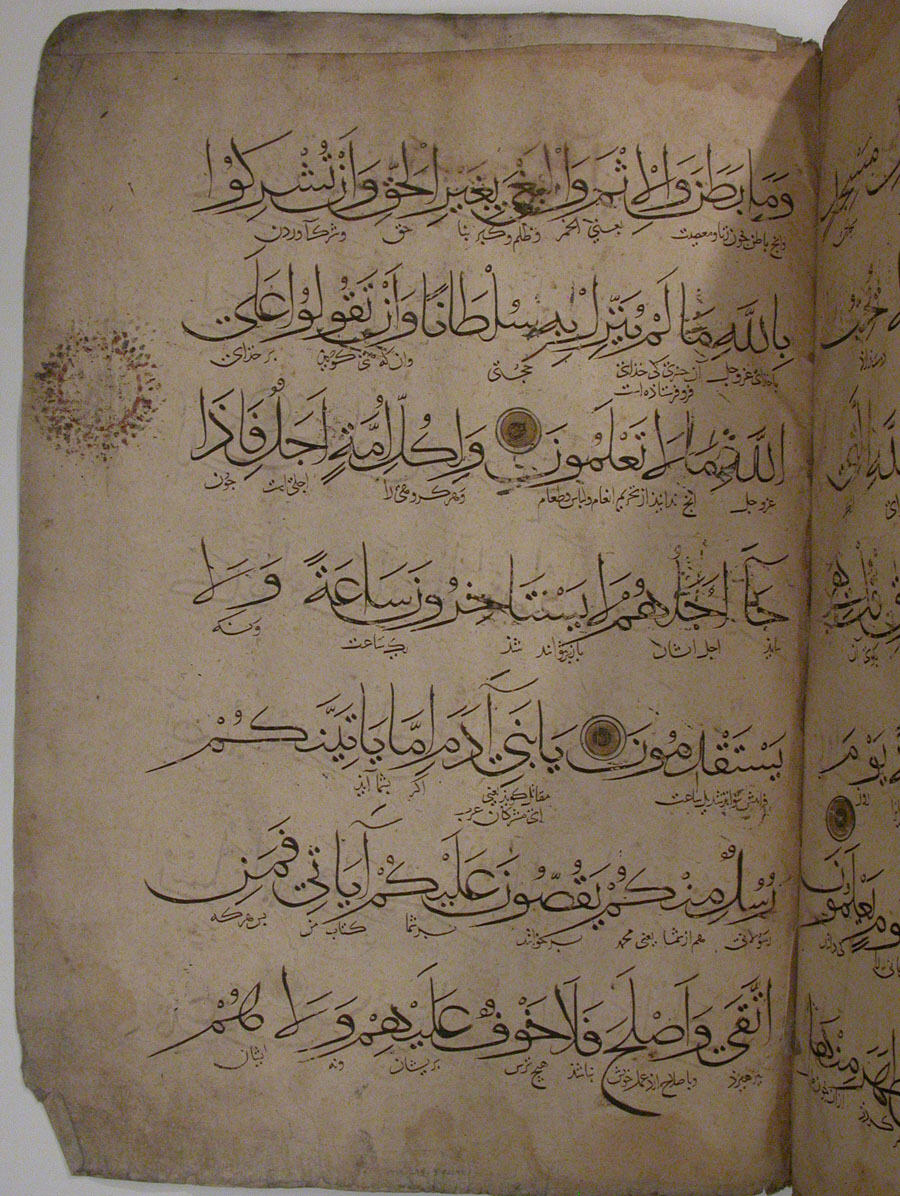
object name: folio from a non illustrated manuscript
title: Folio from a Qur'an Manuscript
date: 1301-1400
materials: gold, ink, paper, watercolor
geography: india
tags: qur'an,calligraphy